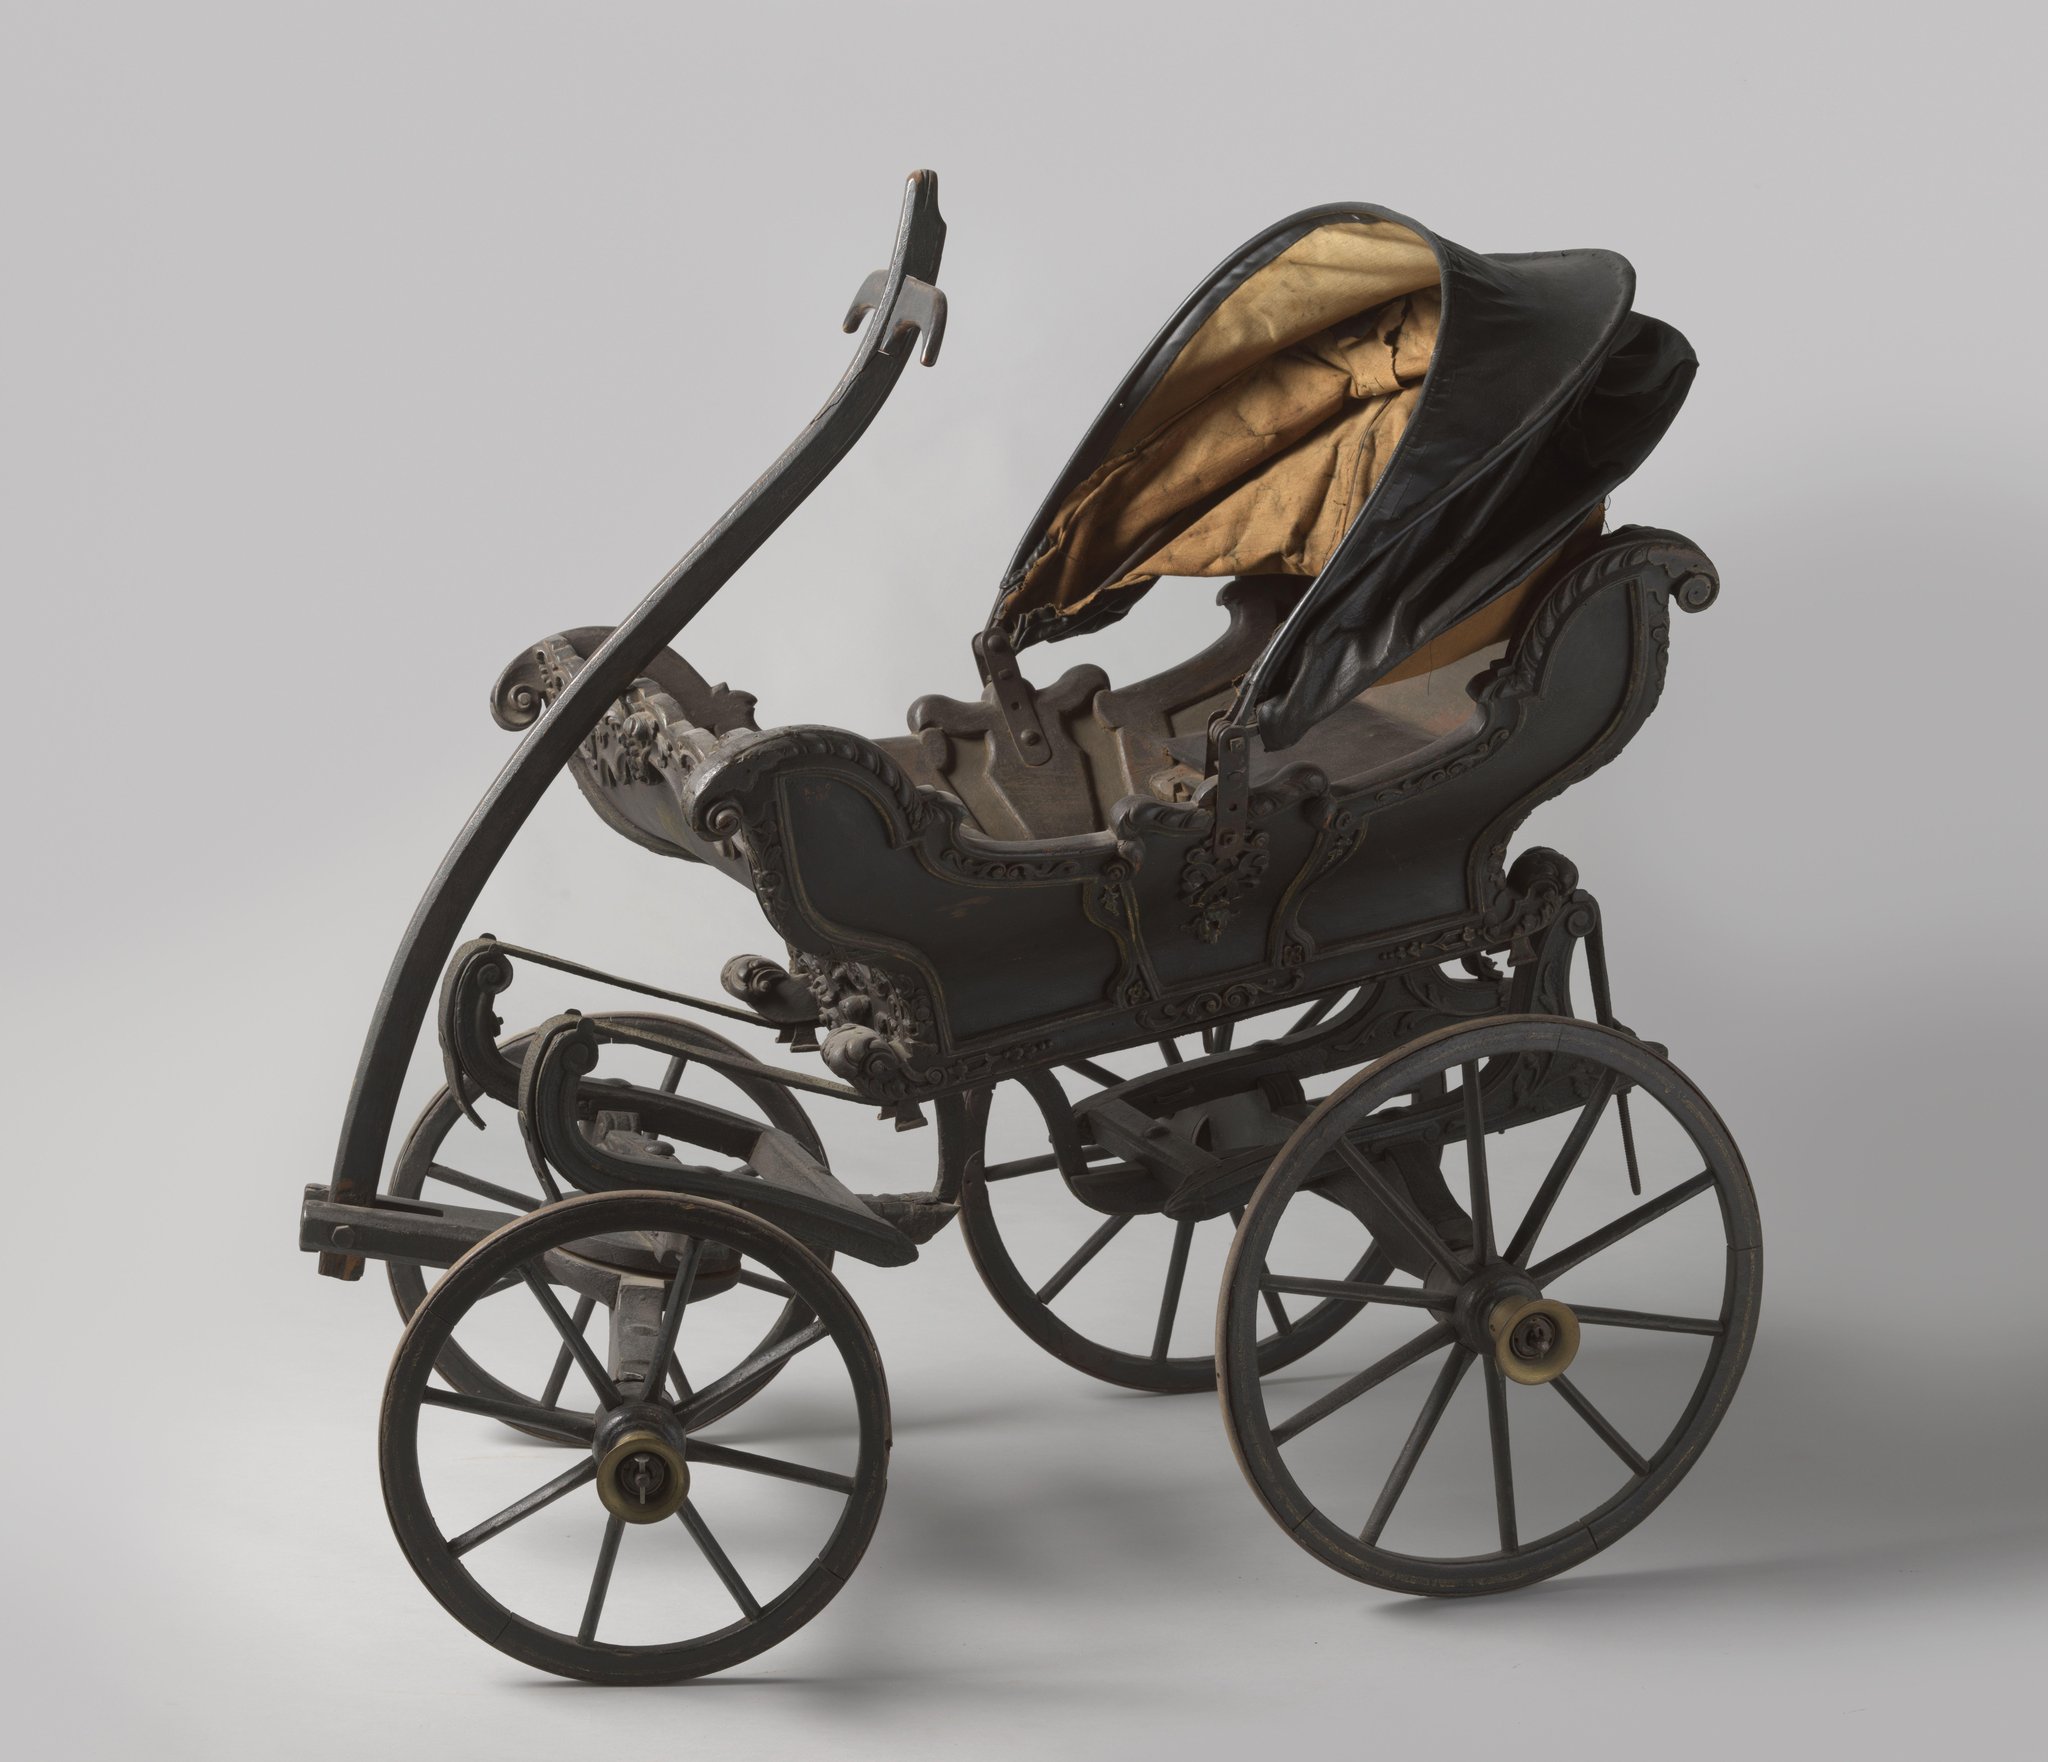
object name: baby carriage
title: Kinderwagen met vier wielen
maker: Anonymous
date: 1740-1760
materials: iron, leather, wood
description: Kinderwagen, donkergroen met wit, met gebeeldhouwde bak. Als middenstuk van het rugpand een geschilderde vruchtenkorf. Op het voorpand bloemen. Kap zonder kleding. Vier wielen, de voorste kleiner dan de achterste.